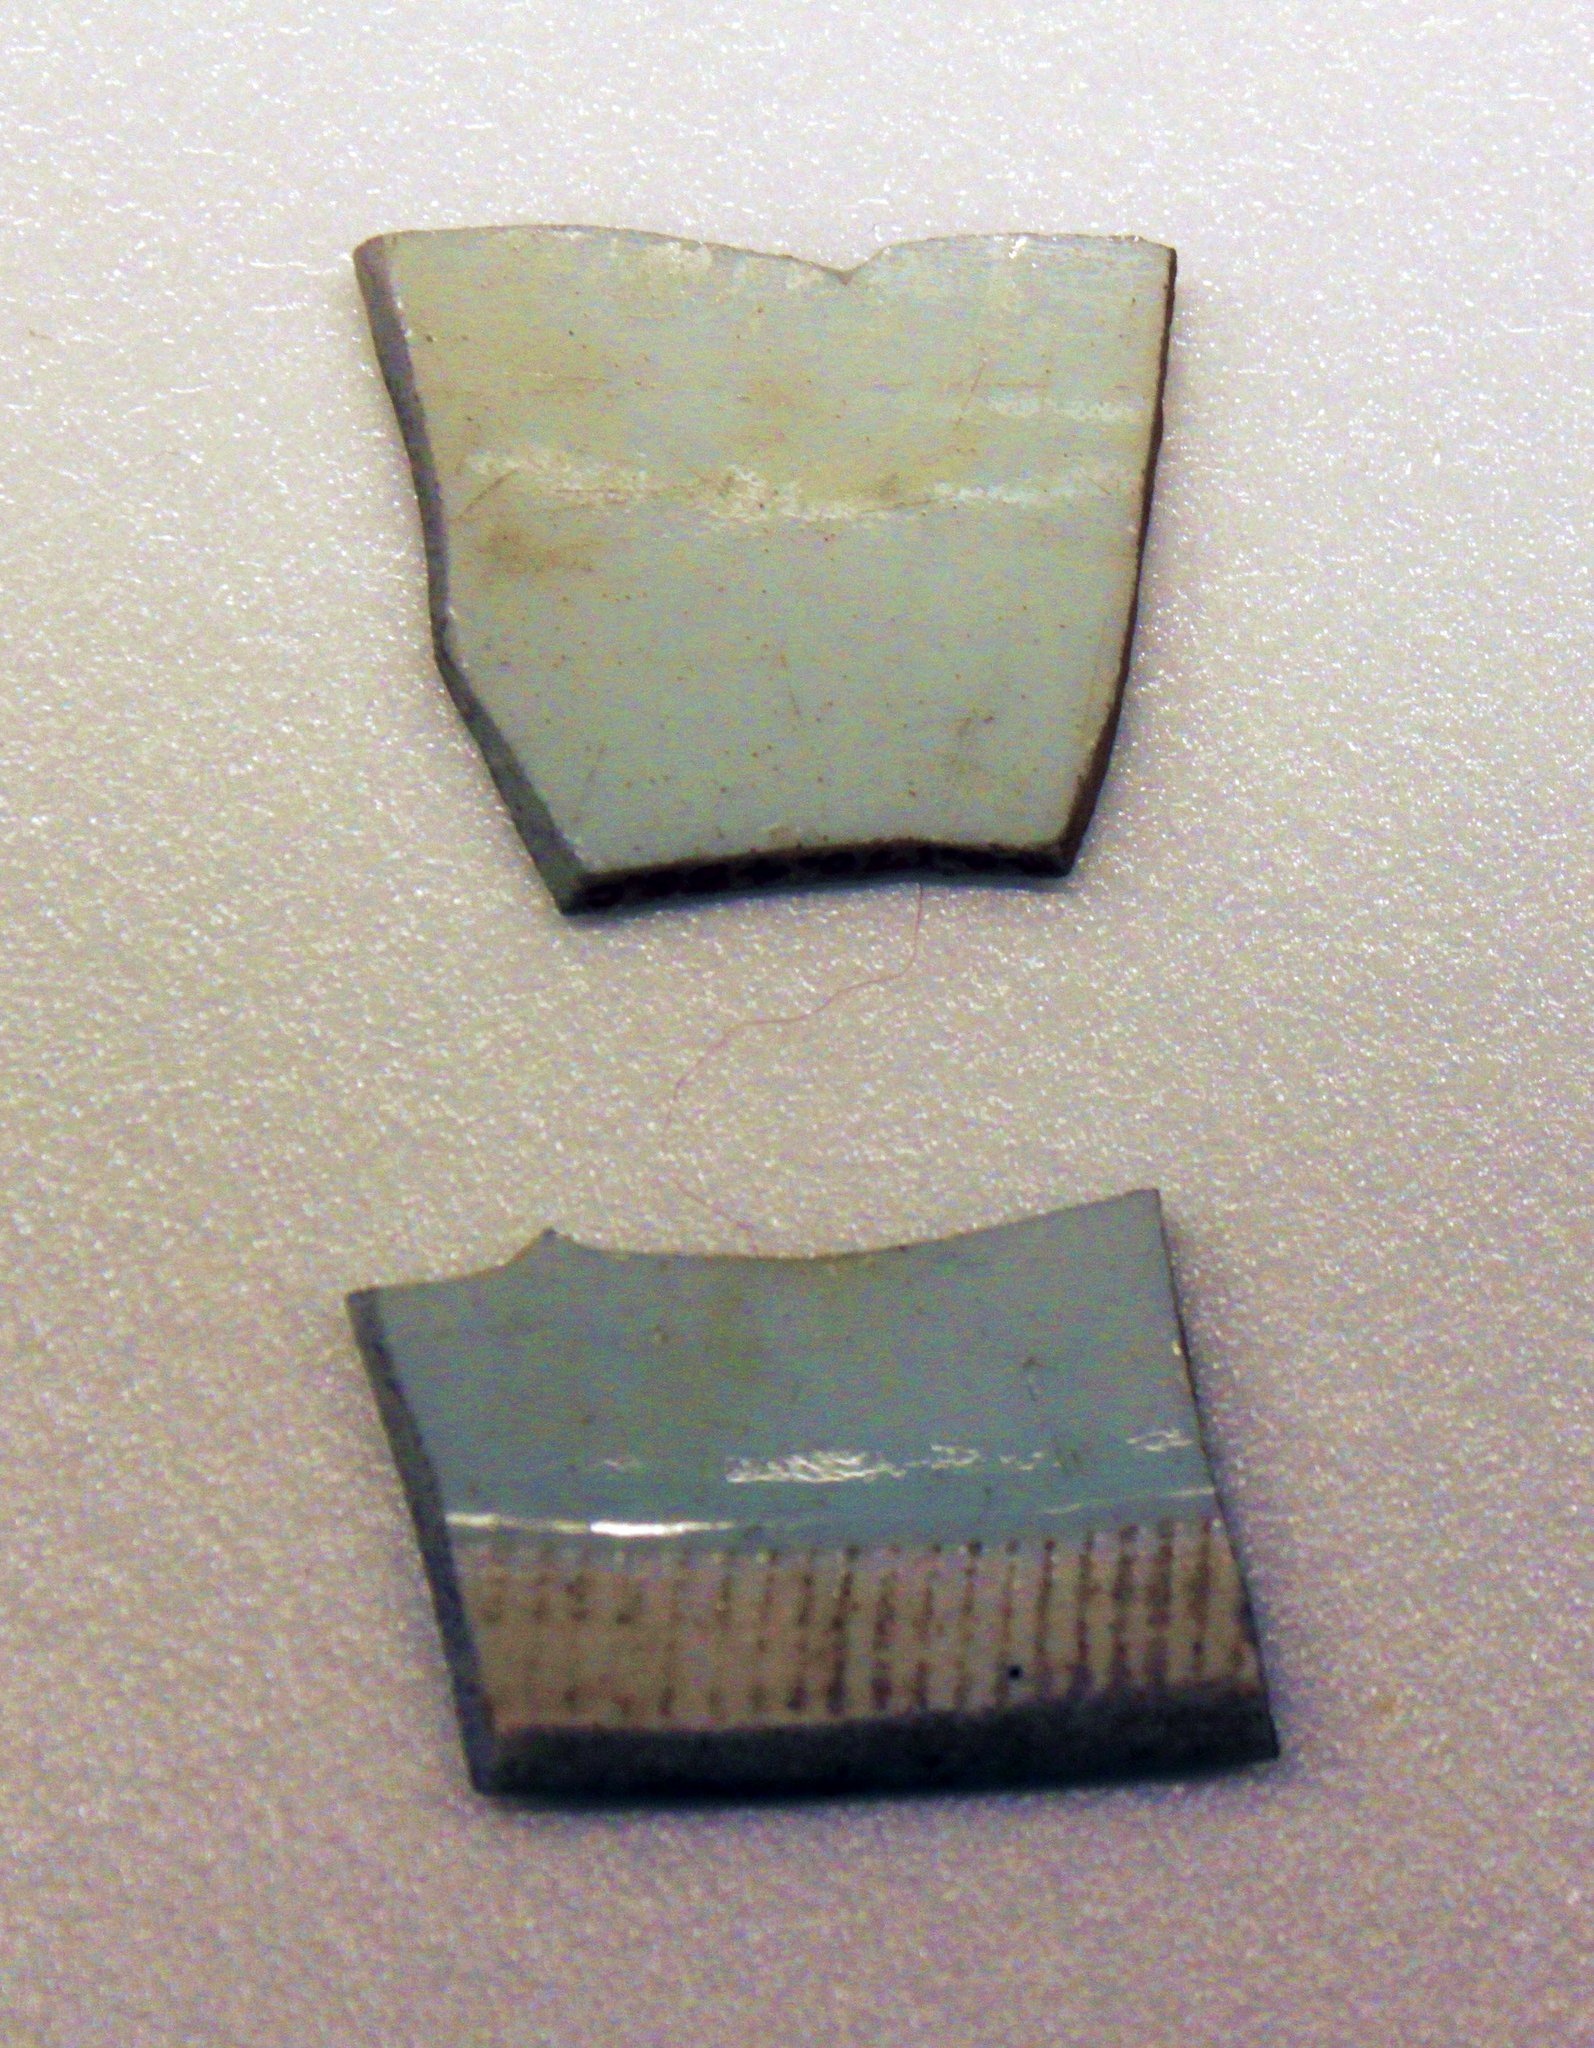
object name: fragment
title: Fragment of a Bowl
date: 801-1000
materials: porcelain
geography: china